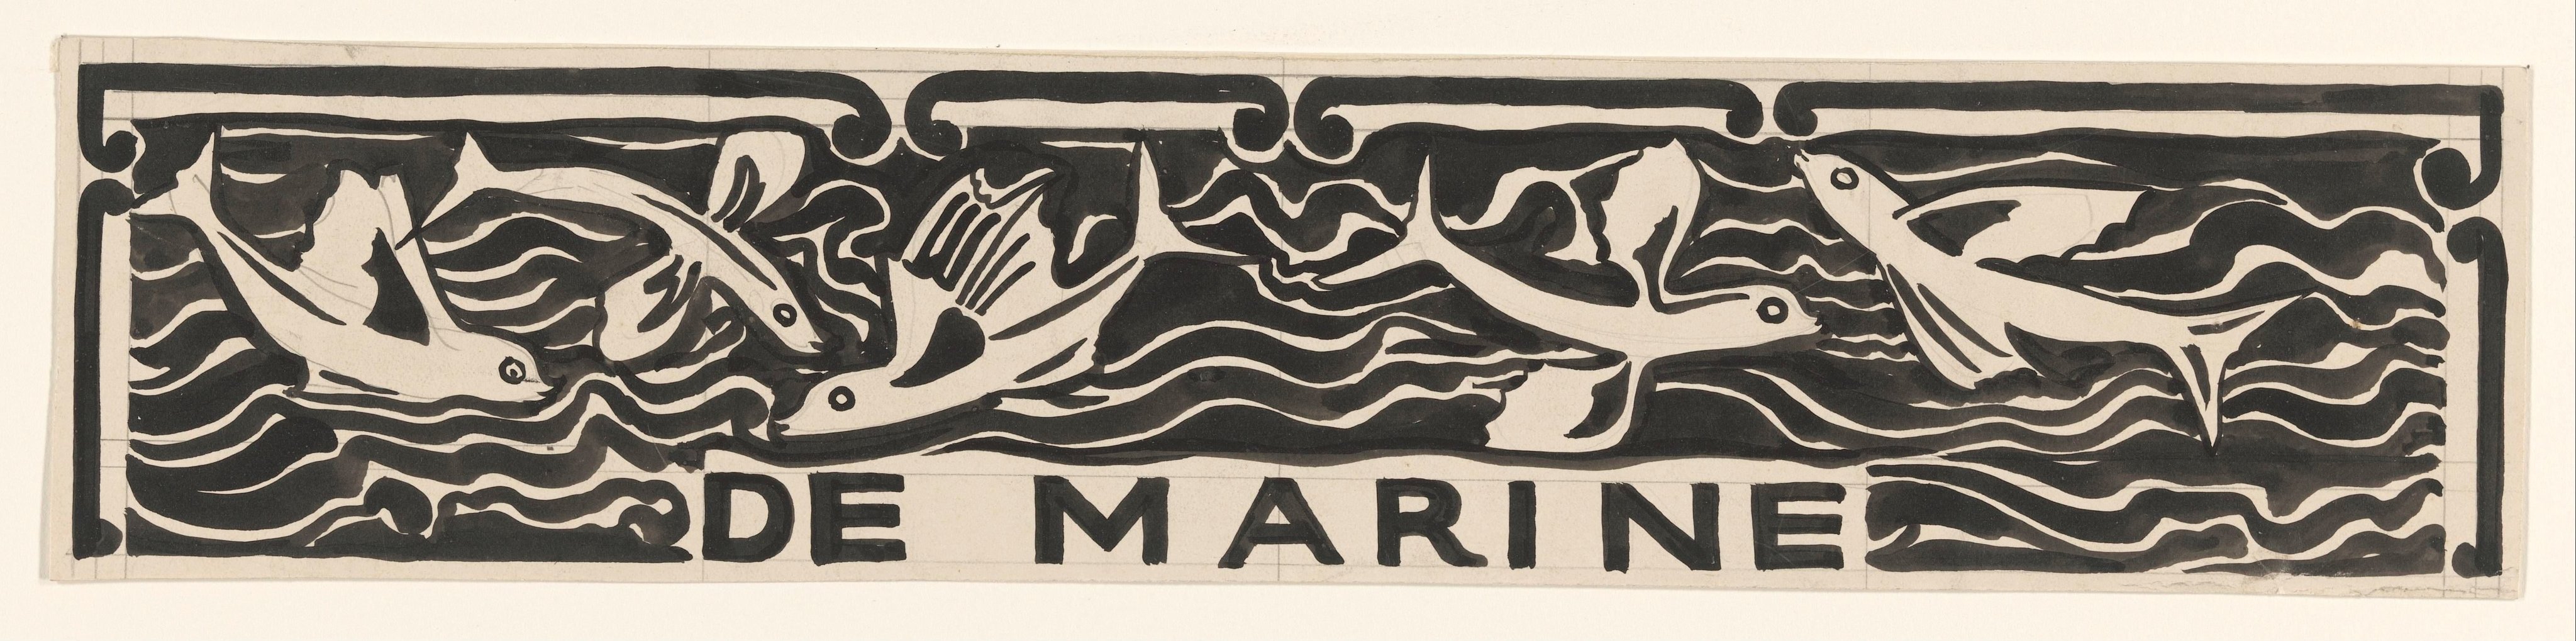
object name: drawing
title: Ontwerp voor een vignet voor De Marine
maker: carel adolph lion cachet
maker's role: draughtsman, print maker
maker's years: 1864-1945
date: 1874-1945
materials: paper, pencil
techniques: brush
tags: land forces (+ marines), bony fishes: flying fish, other ornament derived from animal forms